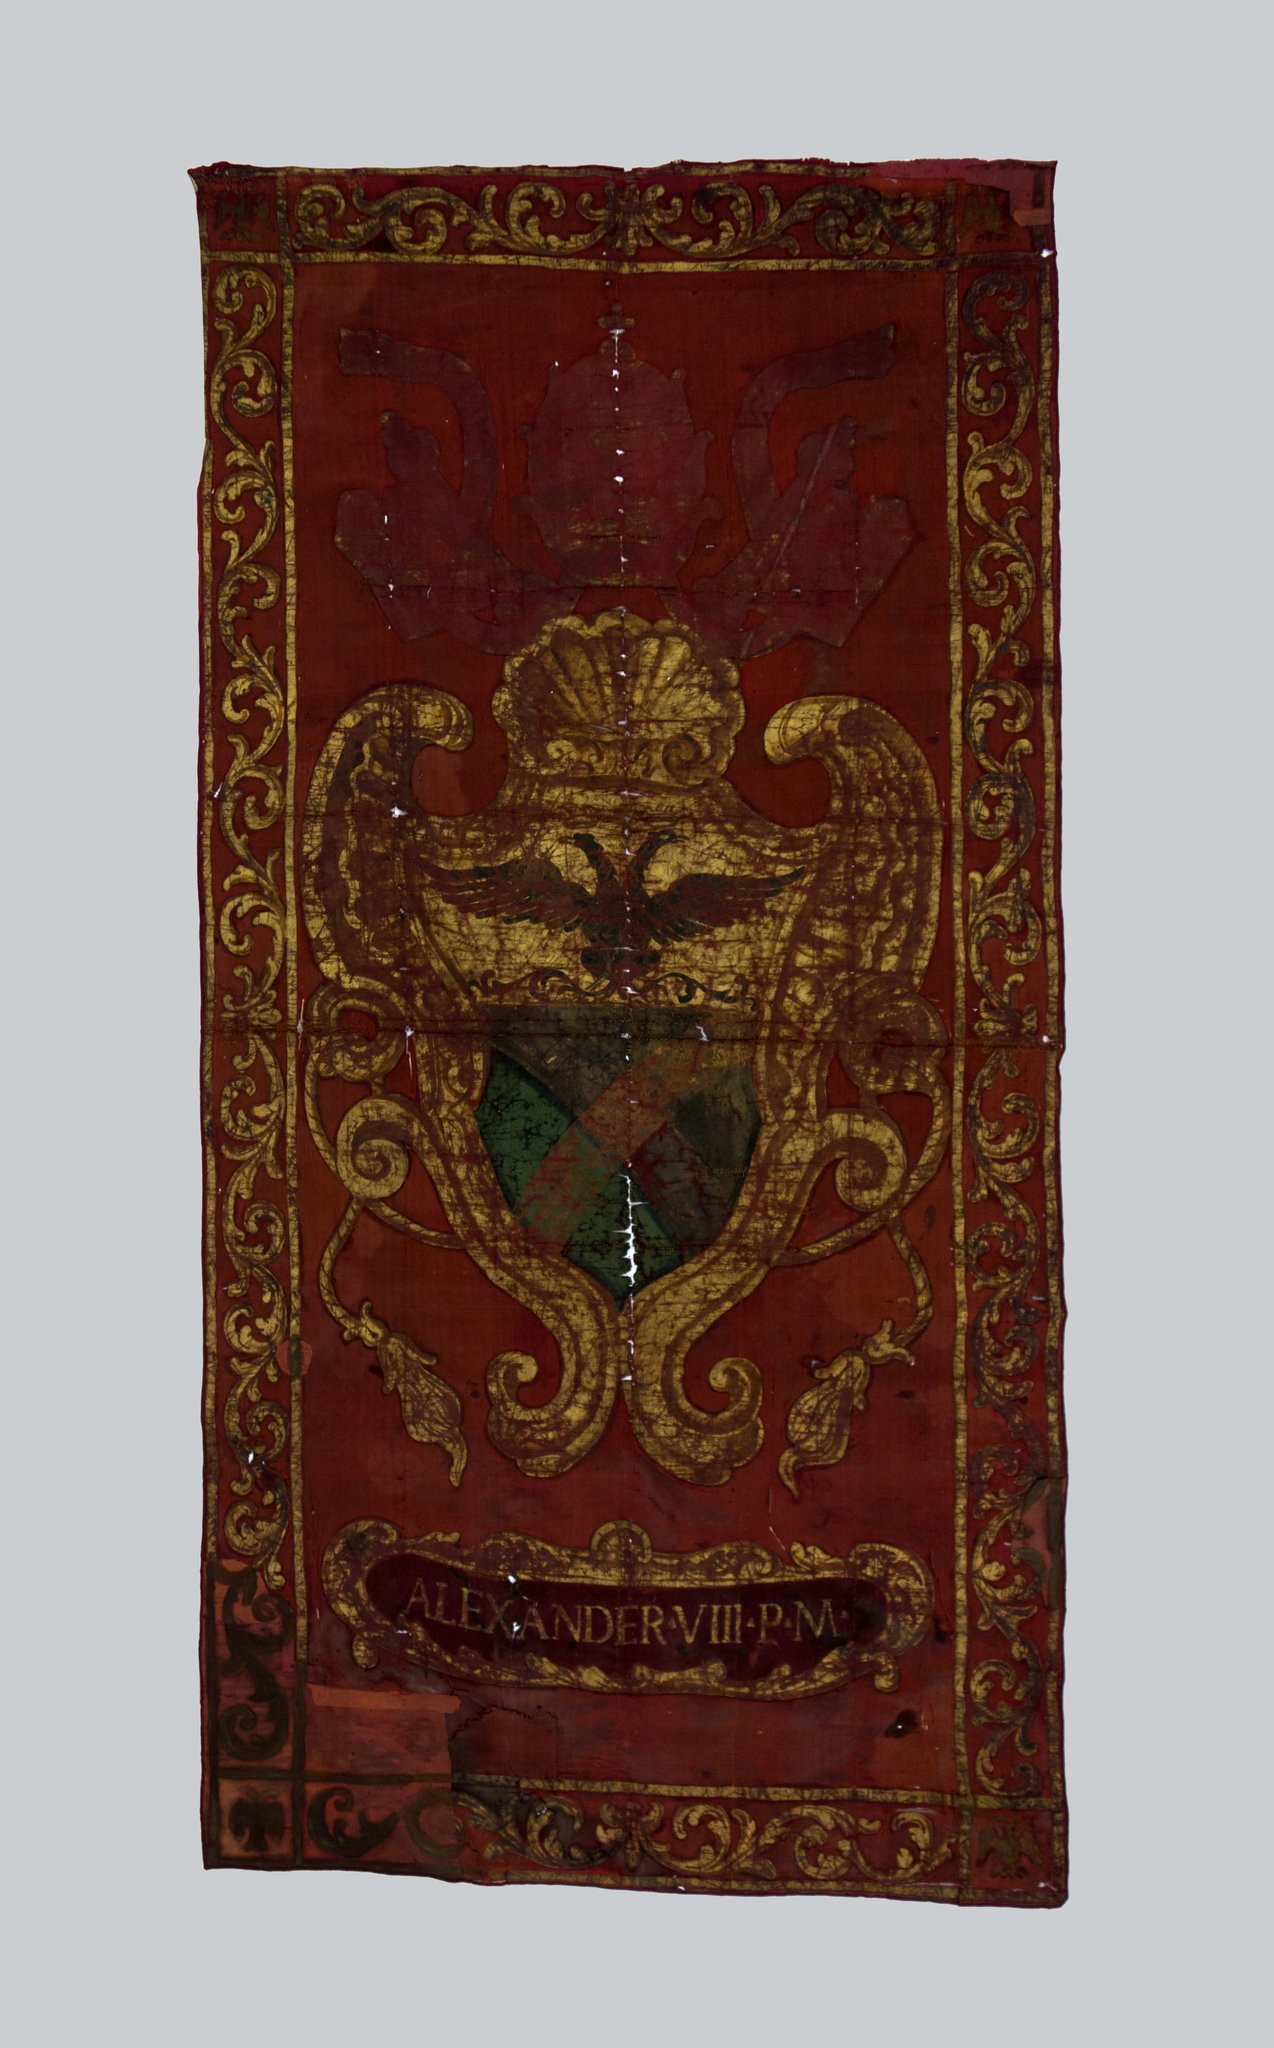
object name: banner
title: Banner of Pope Alexander VIII (reigned 1689–91)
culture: italian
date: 1689-1691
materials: gold, pigment, silk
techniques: polychromy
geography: italy